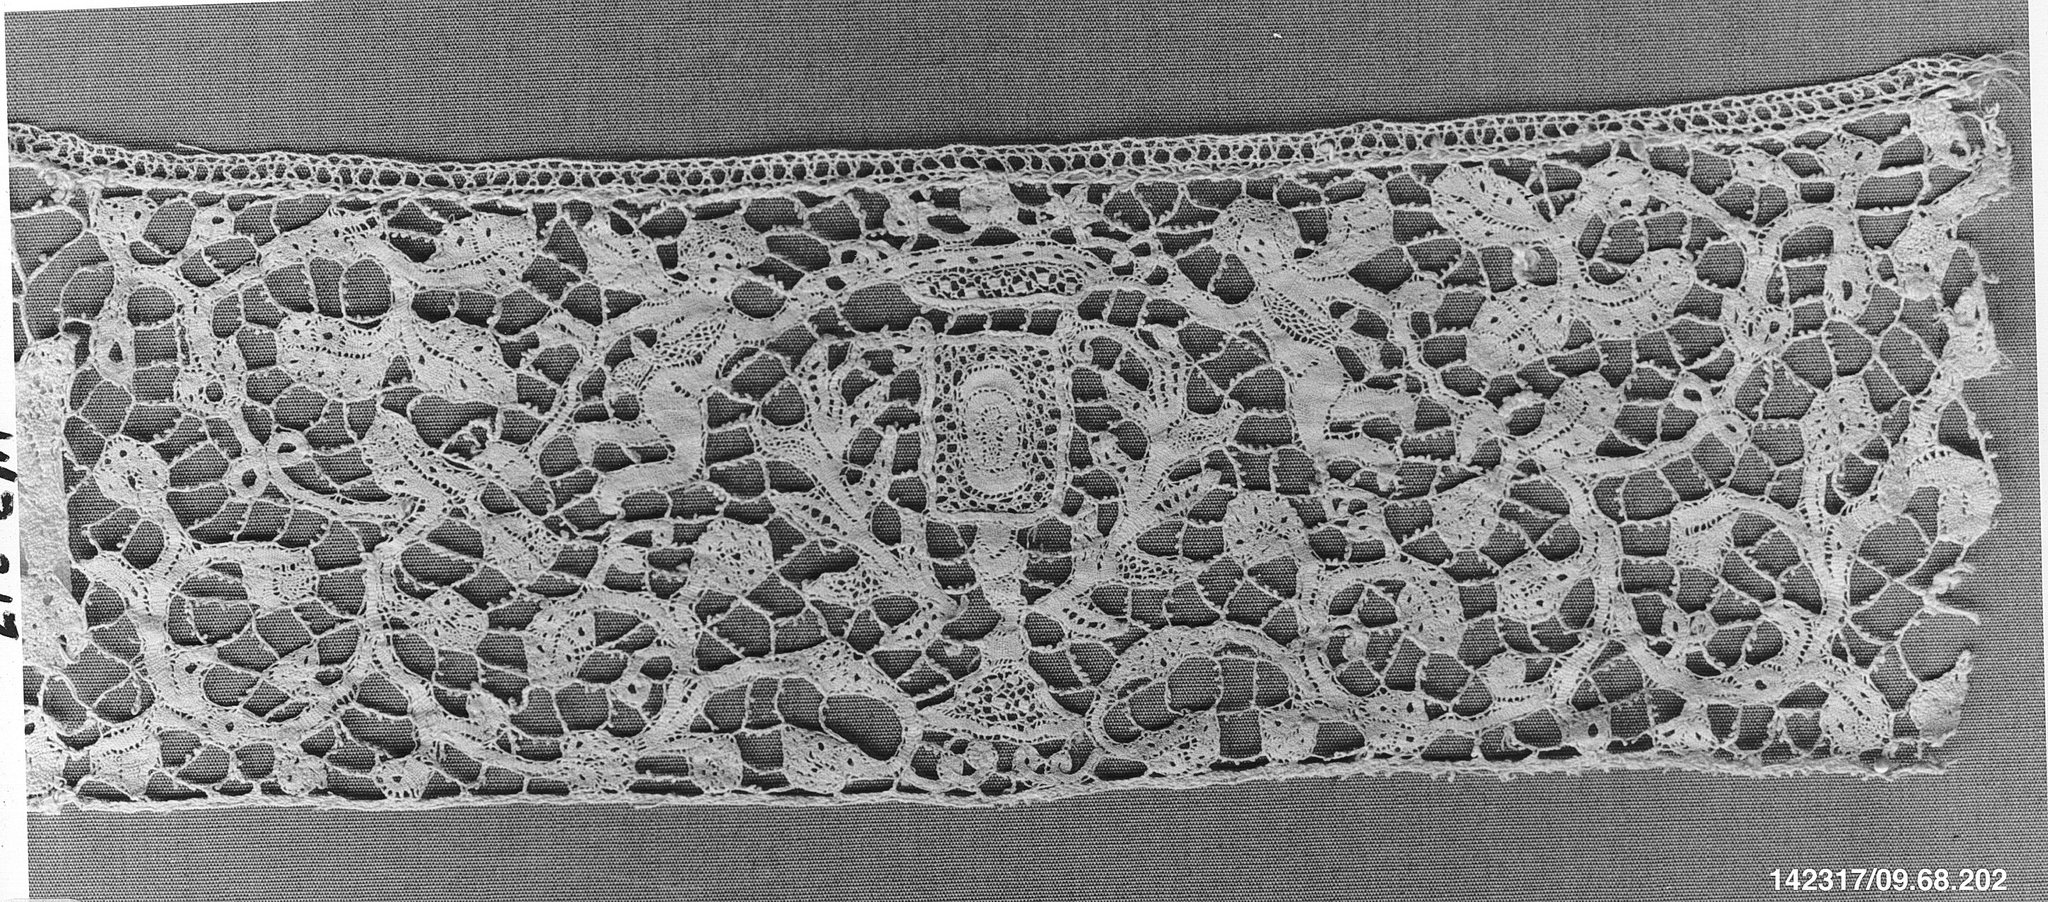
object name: fragment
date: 1701-1733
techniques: lace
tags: human figures